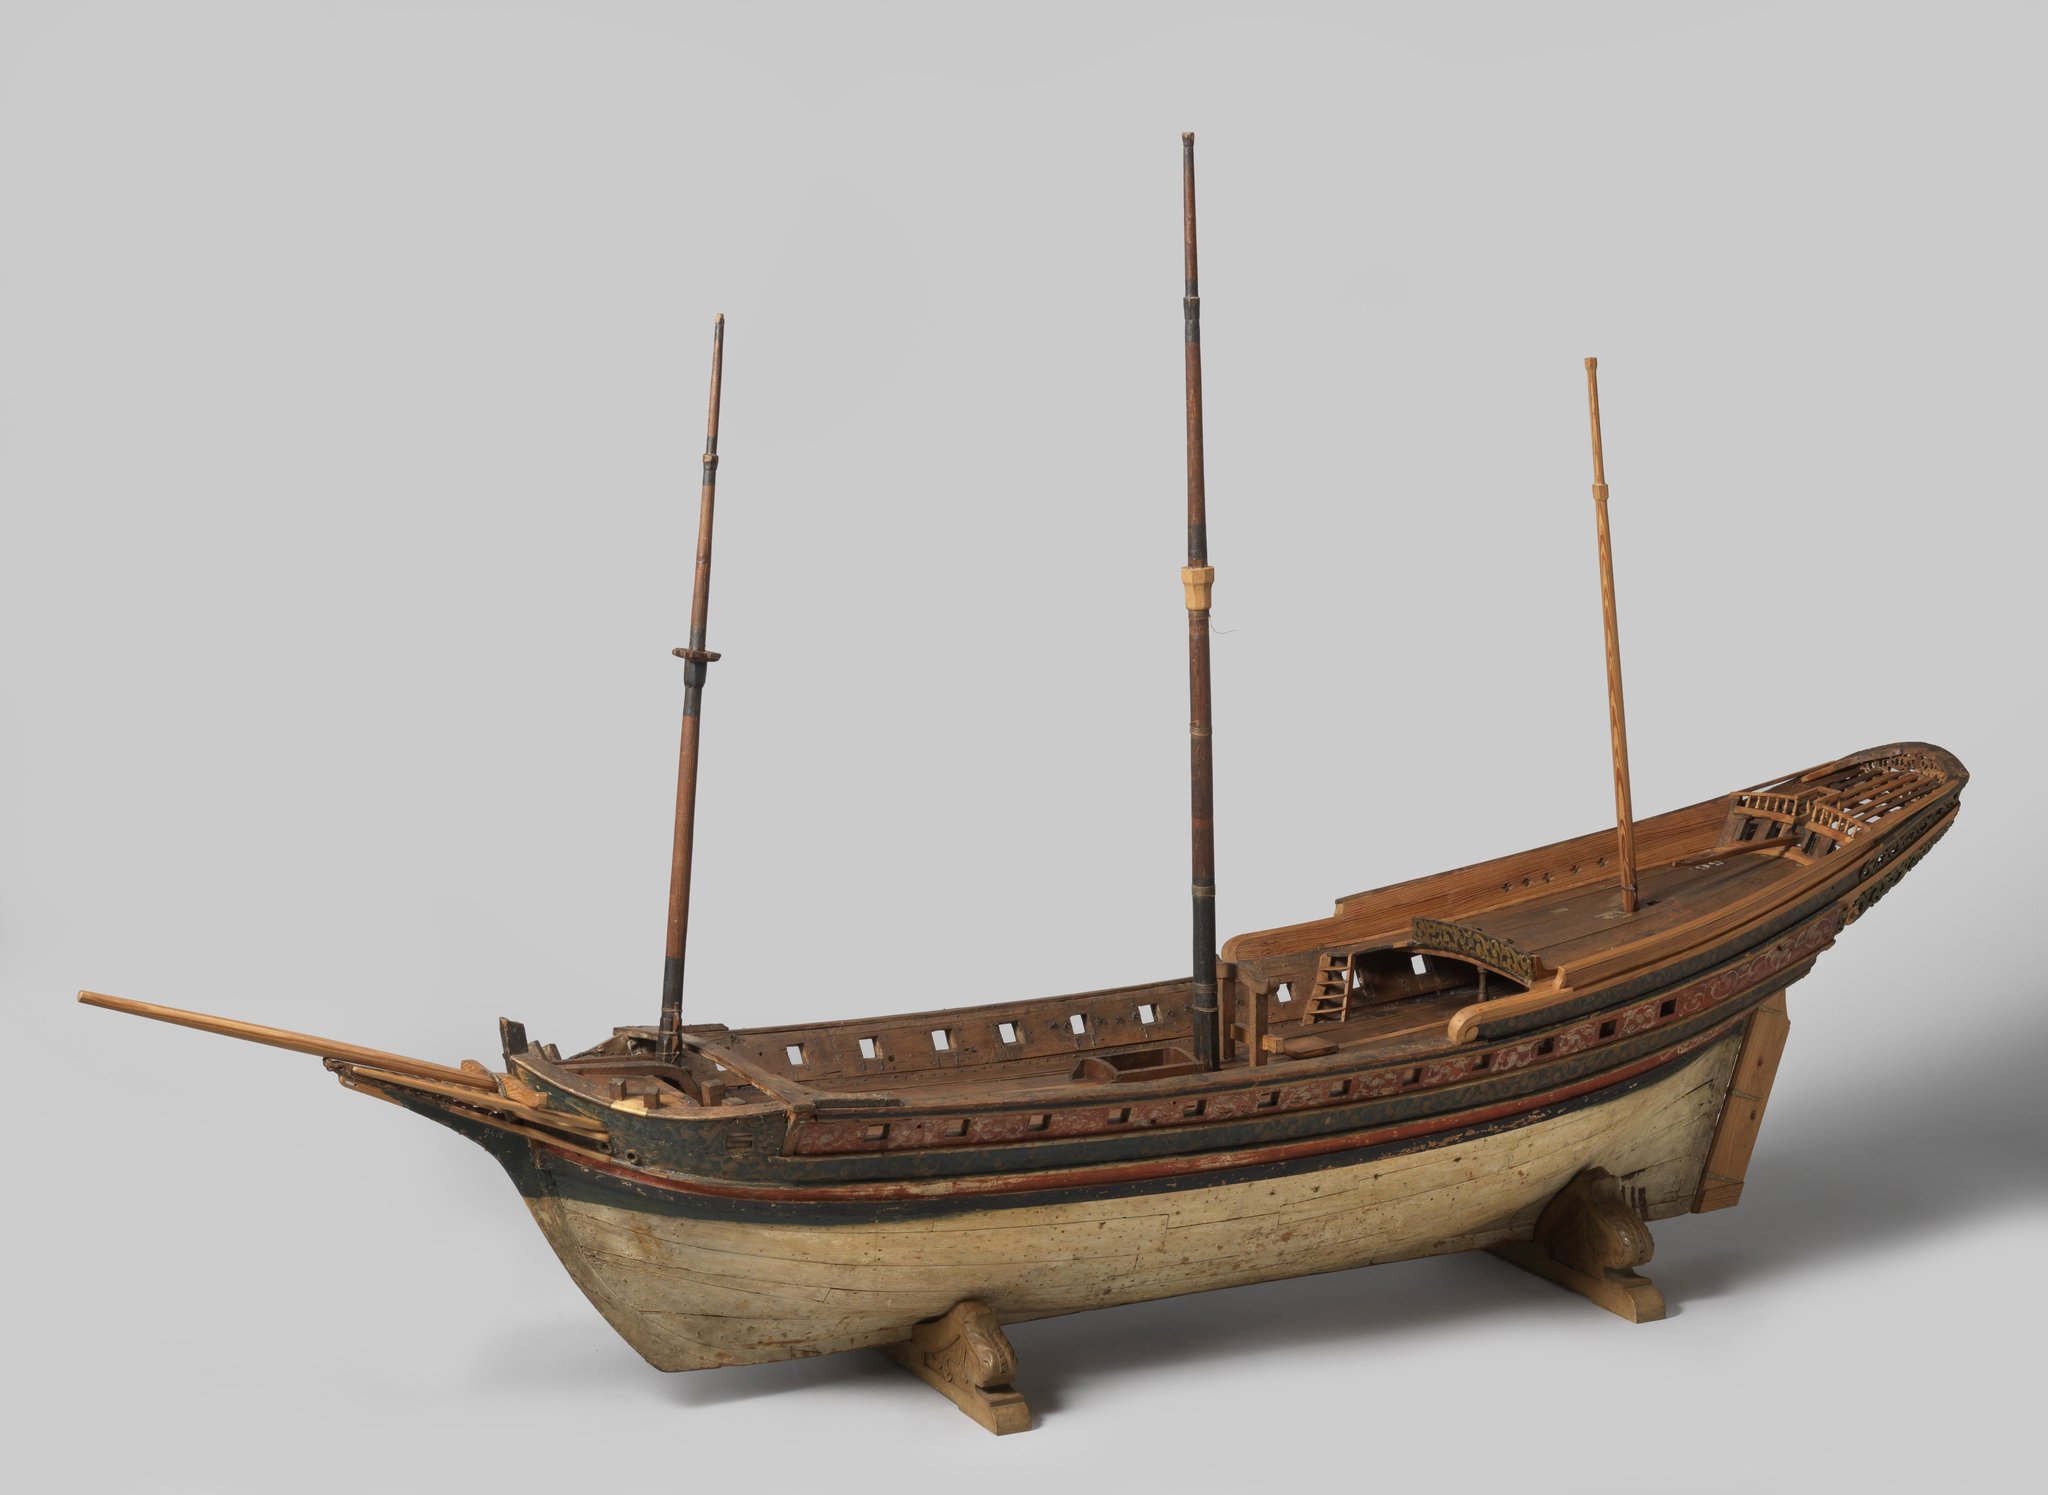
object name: show model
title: Model of a Chebeq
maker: Anonymous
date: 1600-1700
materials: wood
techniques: polychromy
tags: rotterdam, amsterdam, cornelis tromp, brielle, maarten harpertszoon tromp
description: Gepolychromeerd en getuigd spantmodel van een Mediterrane chebec, incompleet. Spitse boeg en vallende, gebogen voorsteven, galjoen met scheg in de vorm van een krul. Naar achter sterk oplopende zeeg, boven de vallende achtersteven een spiegel met ronde billen. Het roer loopt op tot het halfdek, waarover de roerpen vaart. Boven het hek met vensters ligt een achter overstekend campagnedek met hakkebord met snijwerk. De zijden zijn boven het berghout versierd met geschilderd lofwerk. Er is één doorlopend dek met zesentwintig poorten; achter bevindt zich de kajuit, het halfdek en het campagnedek. Voor is een voorplecht en een beting. Van het tuig zijn alleen de grote mast en de bezaansmast bewaard: de fokkemast en de boegspriet zijn 20ste-eeuwse aanvullingen.